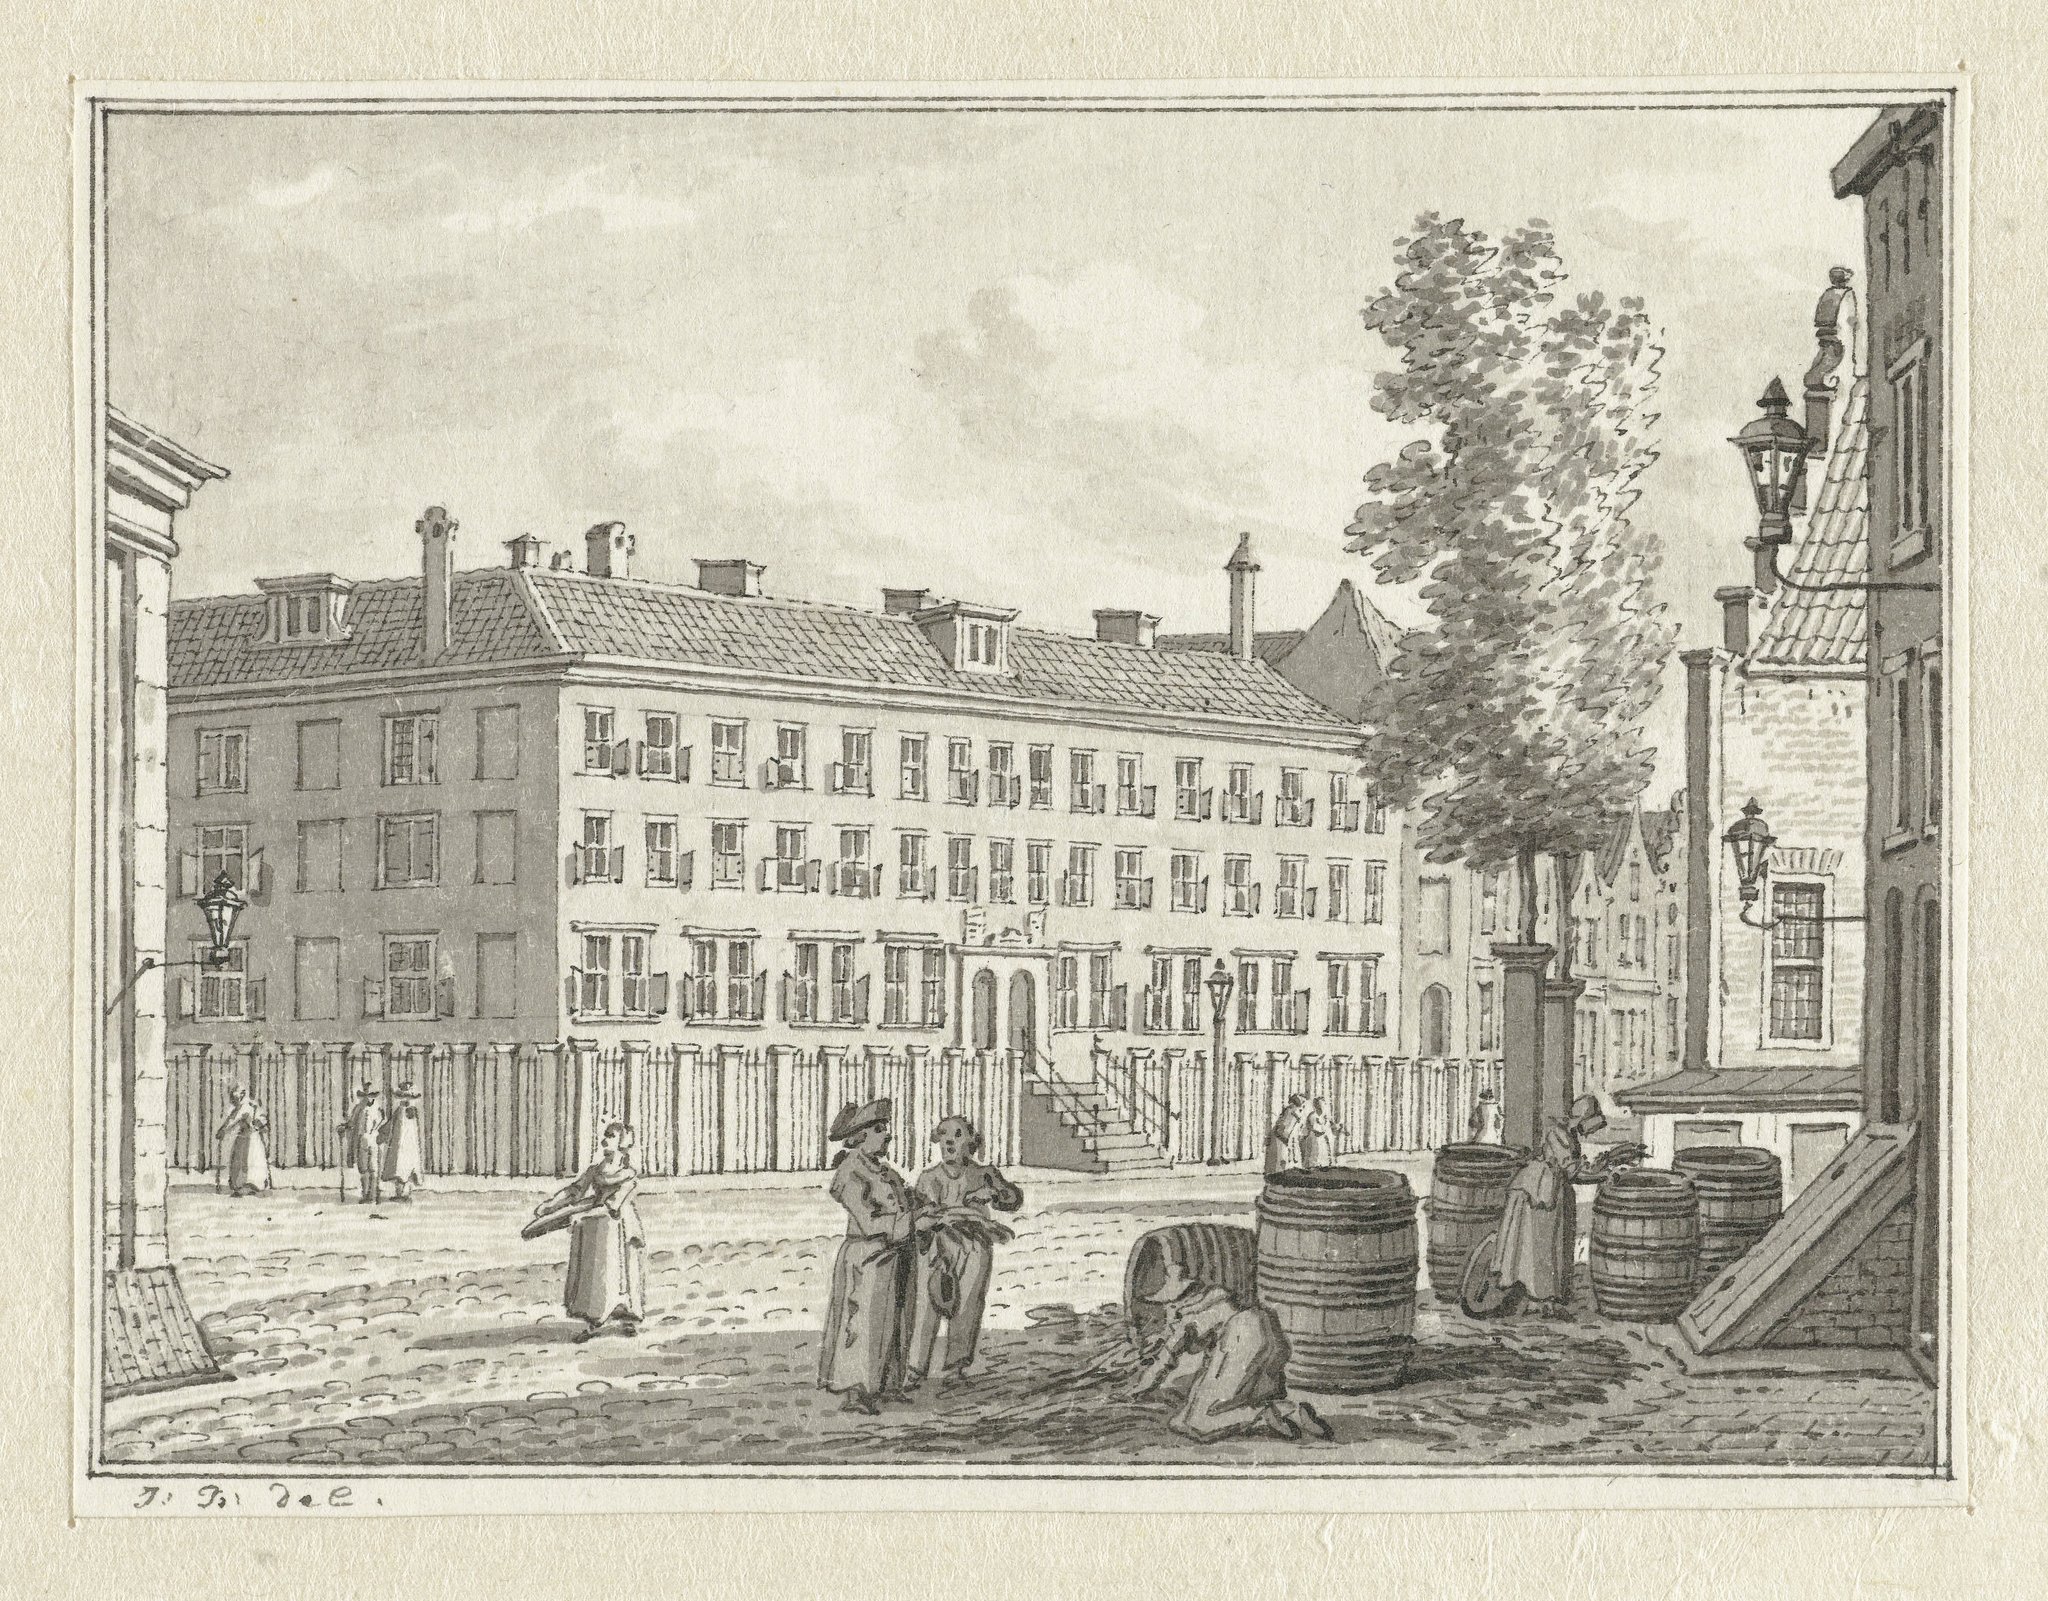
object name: watercolor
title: Een dame schenkt zich een kopje thee in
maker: floris croese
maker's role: draughtsman, print maker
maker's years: 1763-1808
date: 1773-1808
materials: paper, pencil, watercolor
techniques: brush